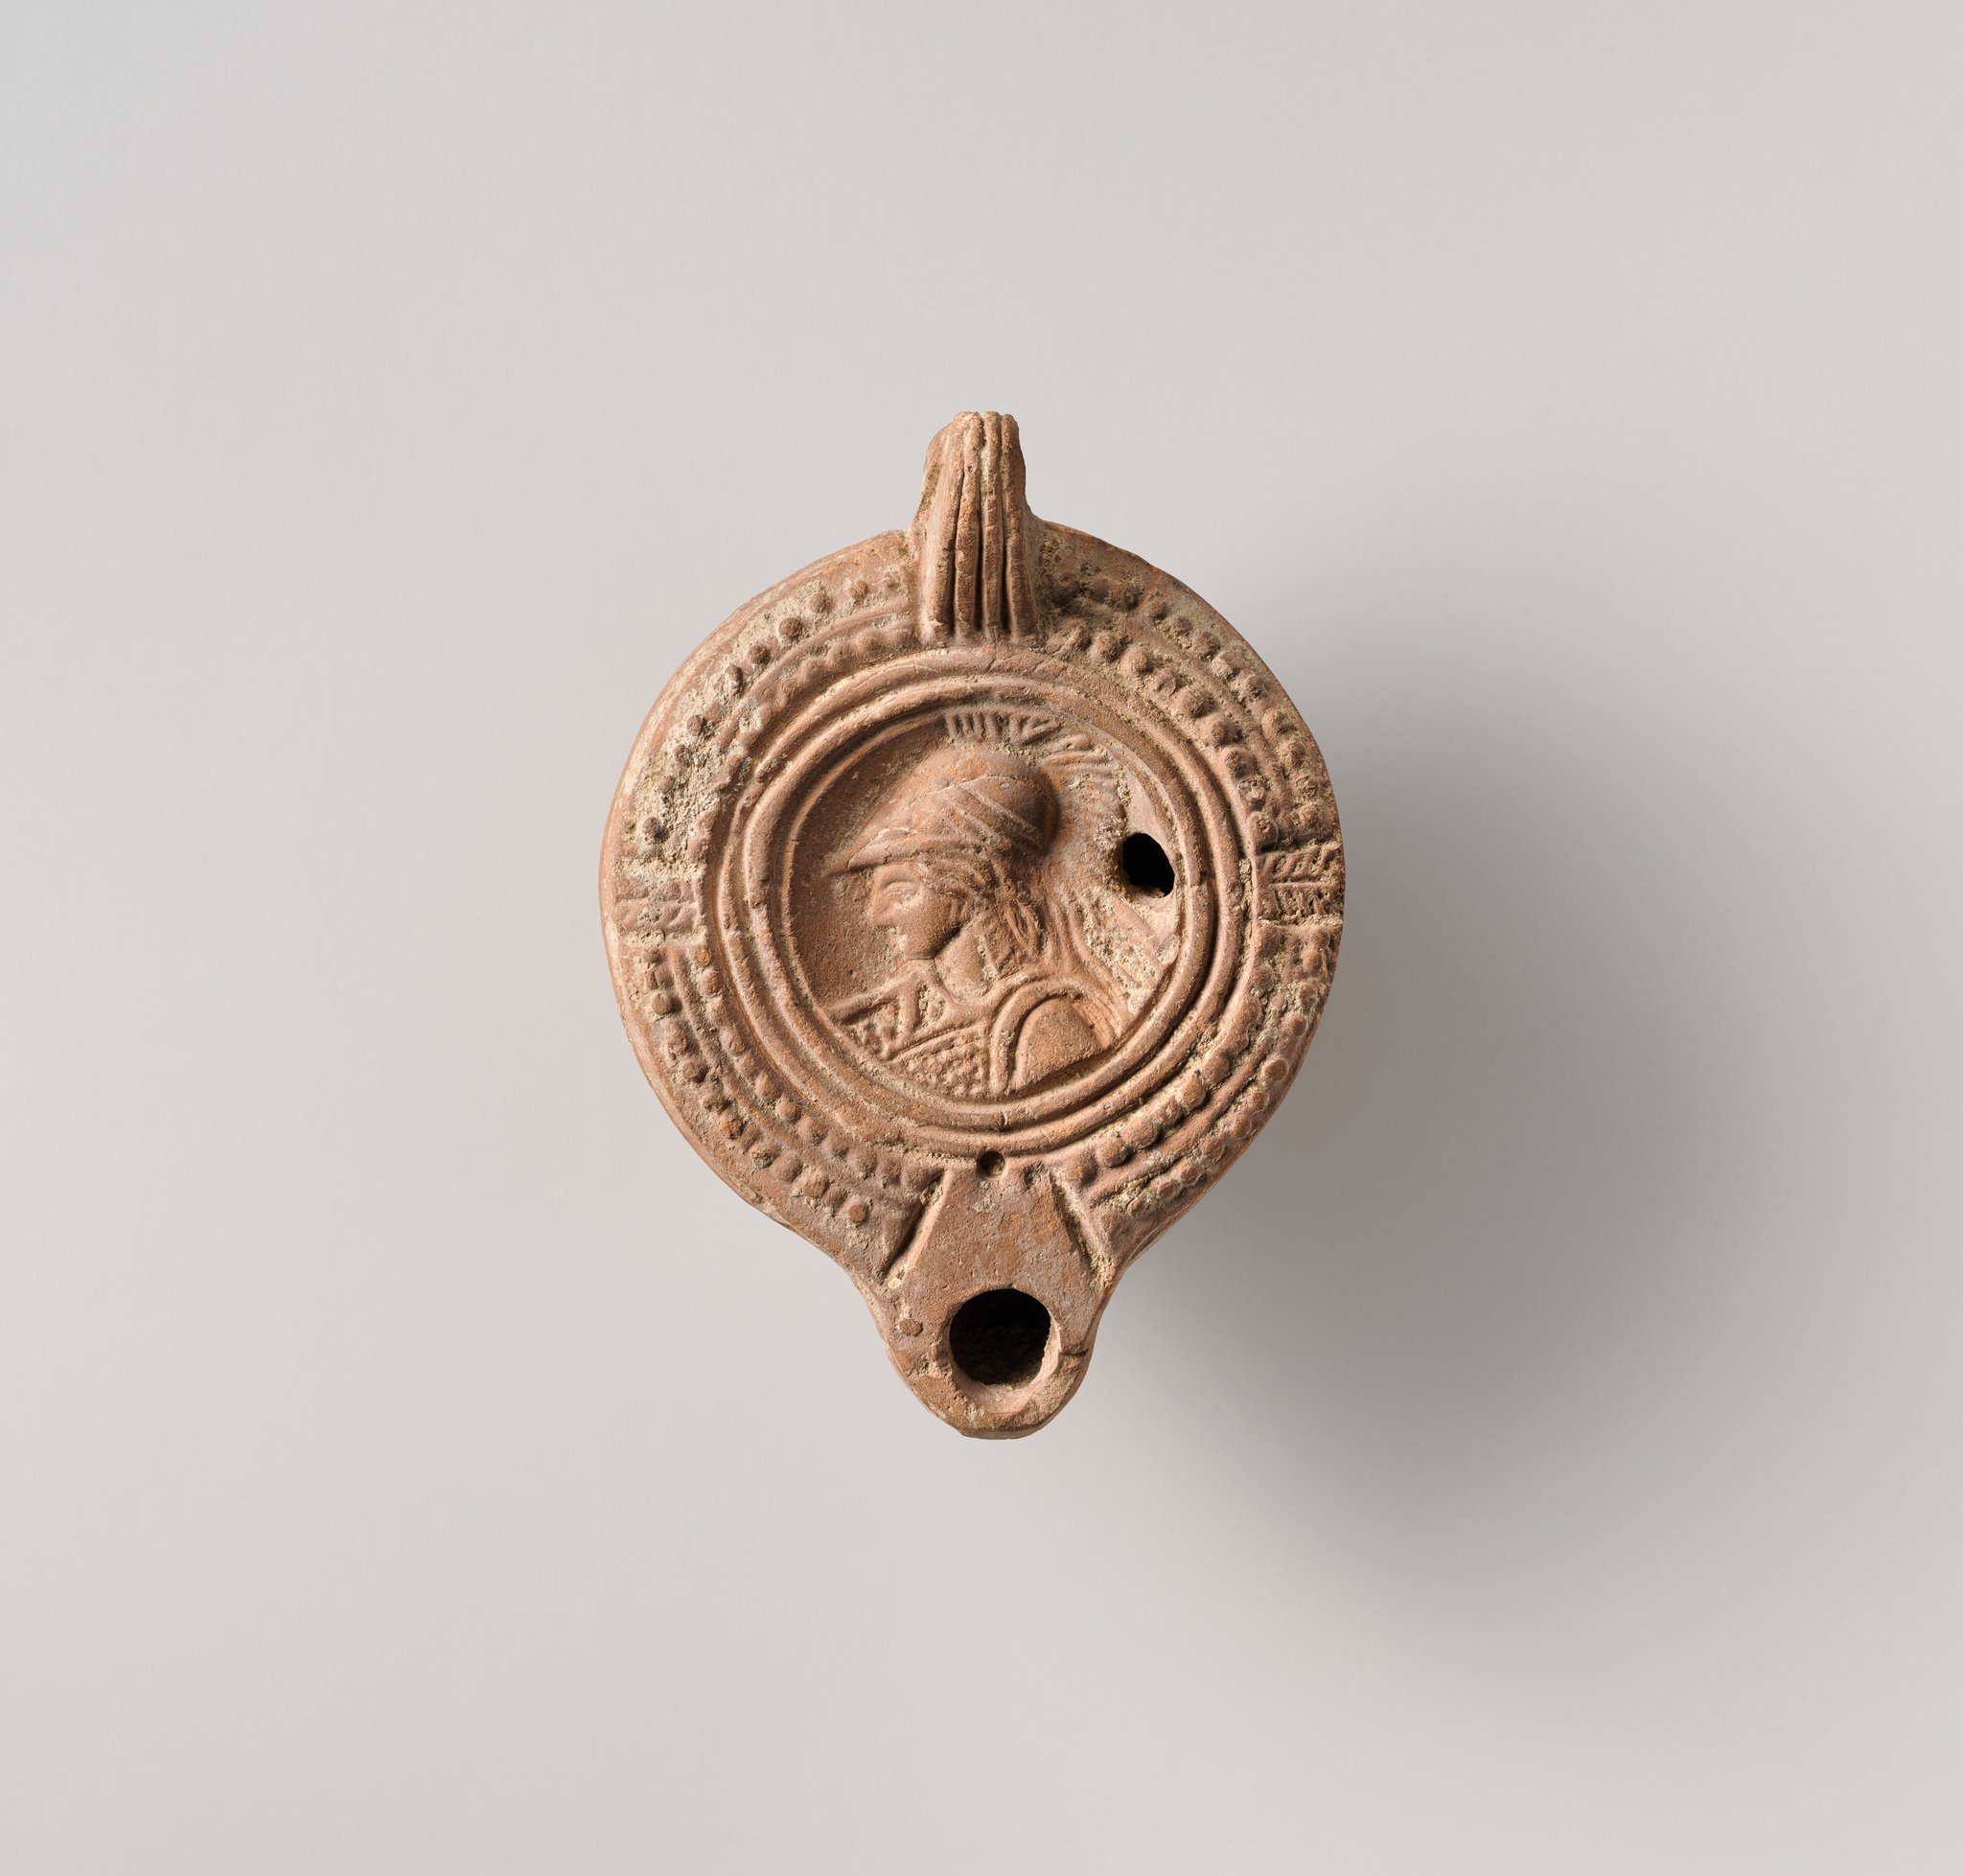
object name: lamp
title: Terracotta oil lamp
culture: roman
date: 201-333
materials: terracotta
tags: athena